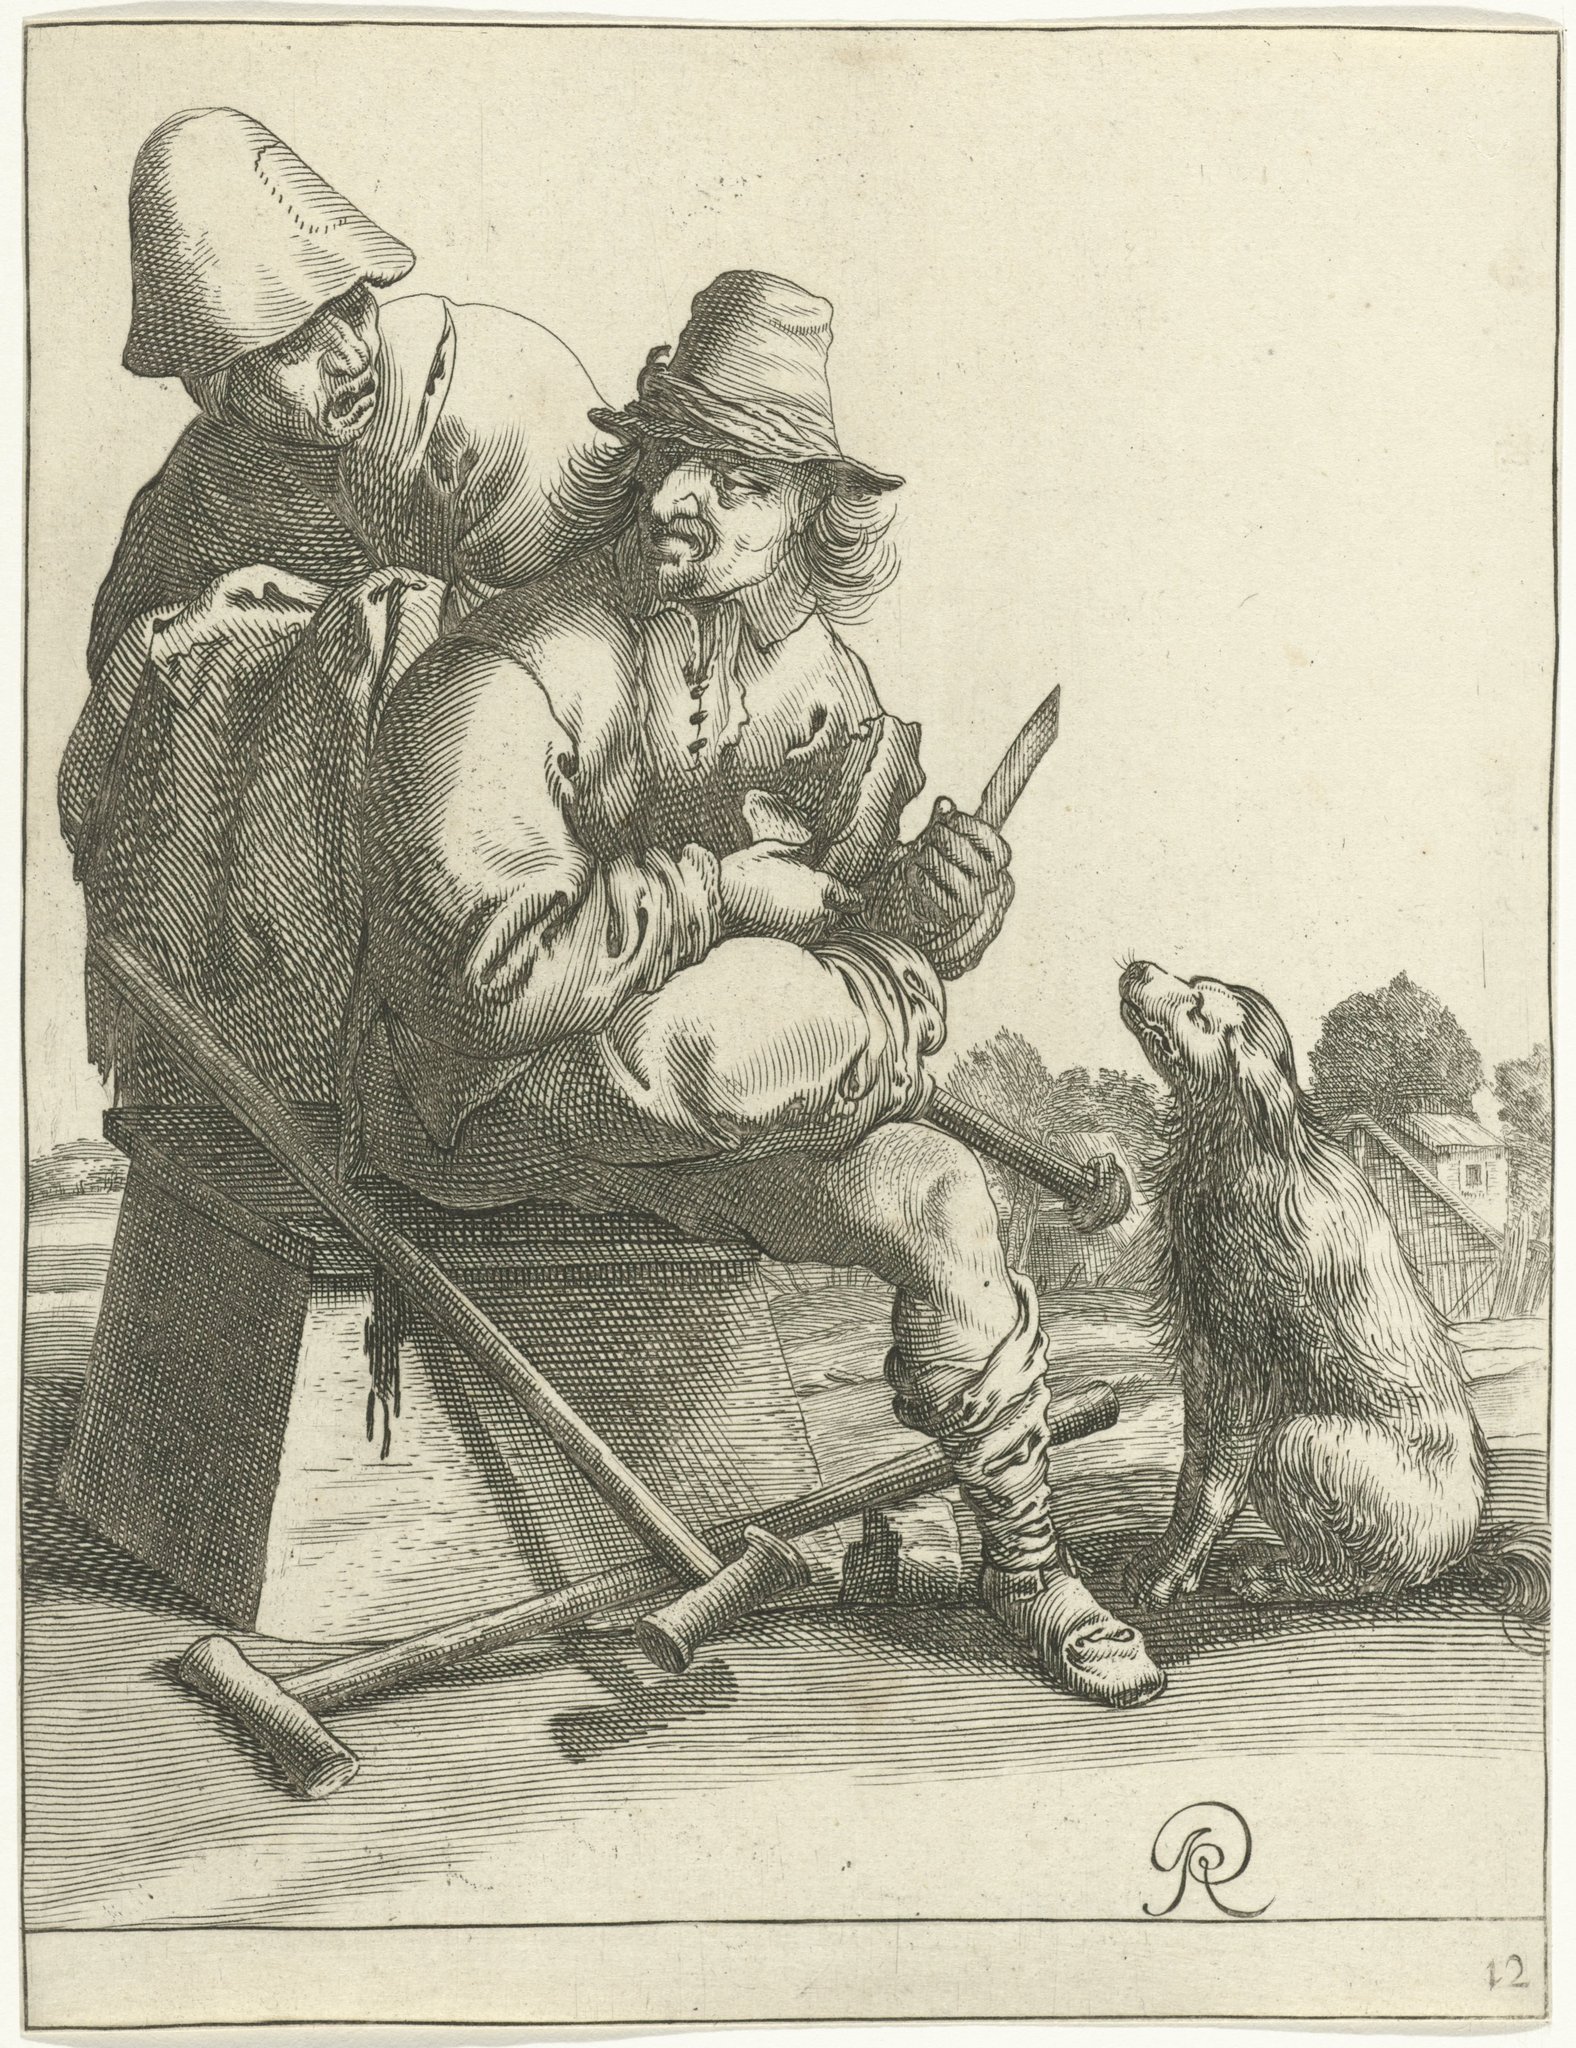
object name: print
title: Bedelaars en boeren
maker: pieter jansz quast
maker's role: draughtsman, painter, print maker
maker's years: 1605-1647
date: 1634-1638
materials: paper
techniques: engraving, etching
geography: the hague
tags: crutches, wooden leg, beggar, tools, aids, implements ~ crafts and industries: knife, dog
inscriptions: collector's mark: Lugt 2228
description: Een bedelaar met een houten been zit op een blok en snijdt vlees of brood met een mes. Achter hem staat een andere landloper en voor hem zit een hond die de neus in de richting van het voedsel houdt. De prent maakt deel uit van een serie van zesentwintig prenten met bedelaars en boeren.